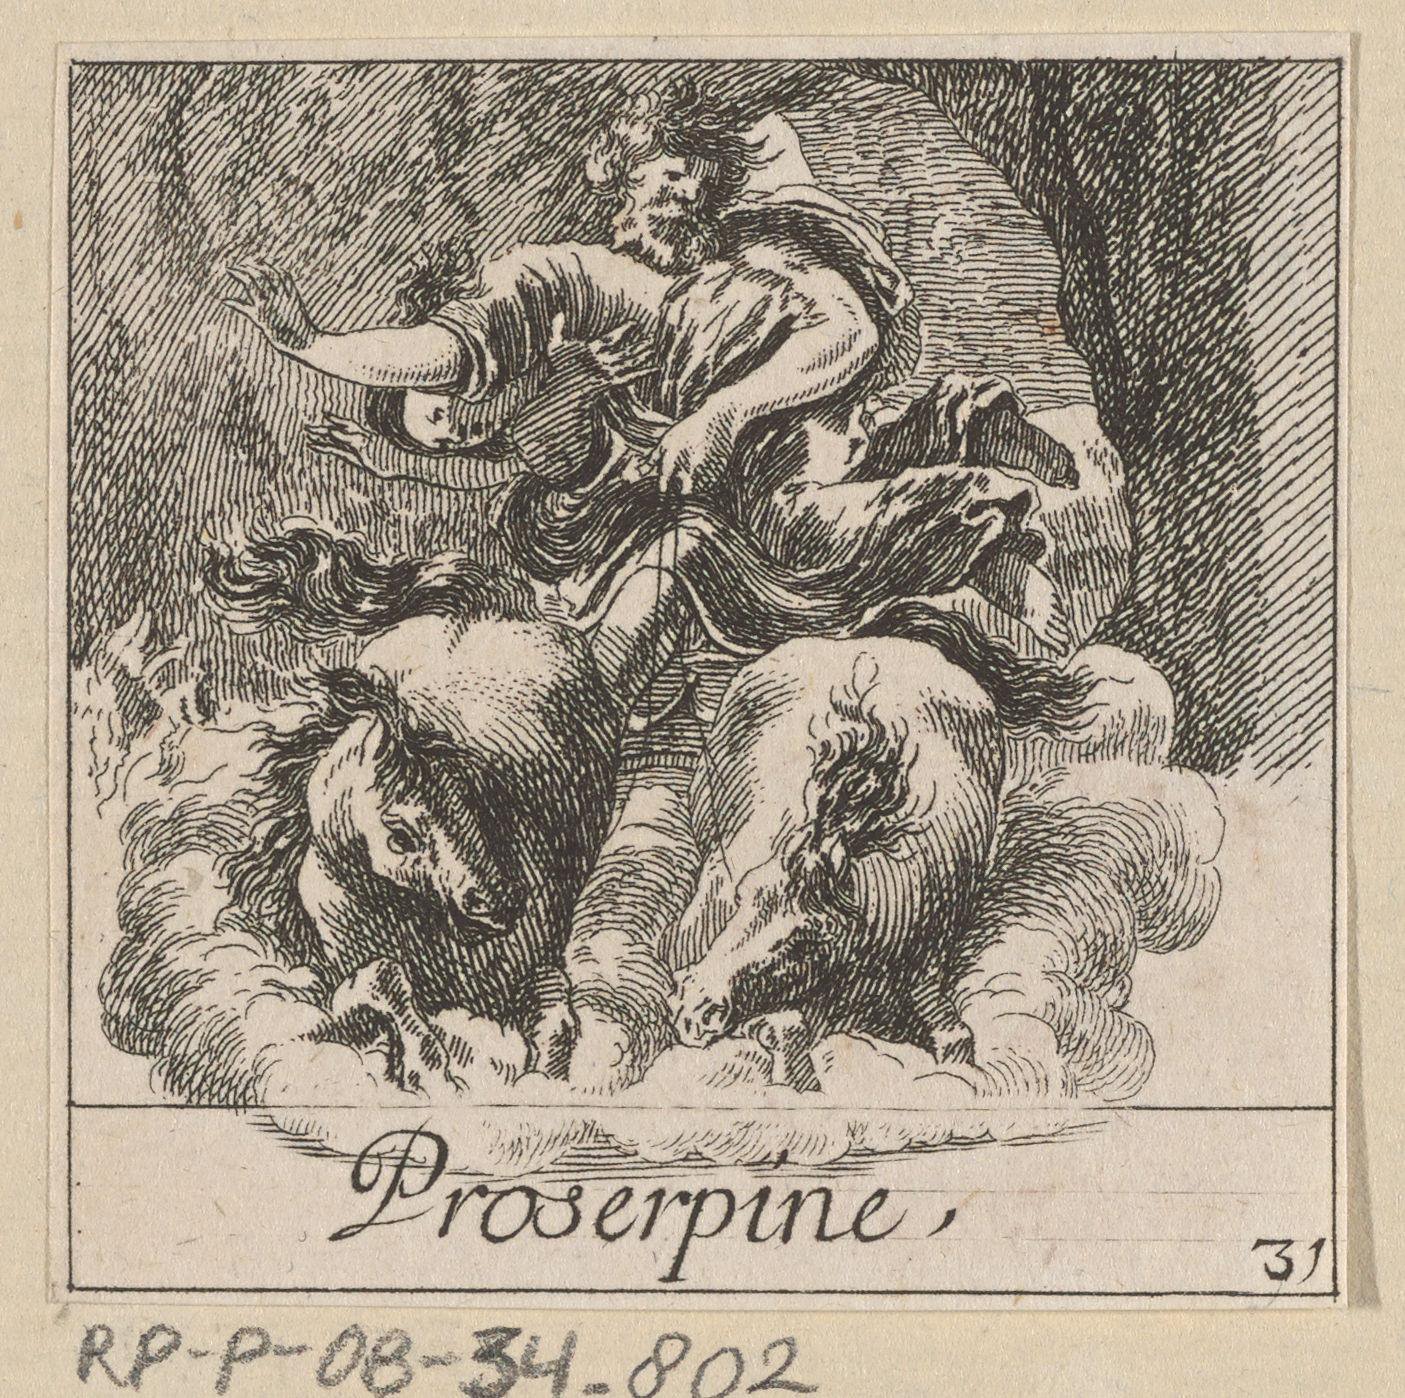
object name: print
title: Jeu des fables (kopie)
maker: Anonymous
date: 1620-1664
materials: paper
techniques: etching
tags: (story of) proserpina (persephone, core), libera, the rape of proserpina (by pluto in his chariot); possibly with diana and minerva trying to rescue her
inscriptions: collector's mark: Lugt 240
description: Prent uit een reeks van 54 genummerde speelkaarten met voorstellingen uit de Metamorfosen van Ovidius.